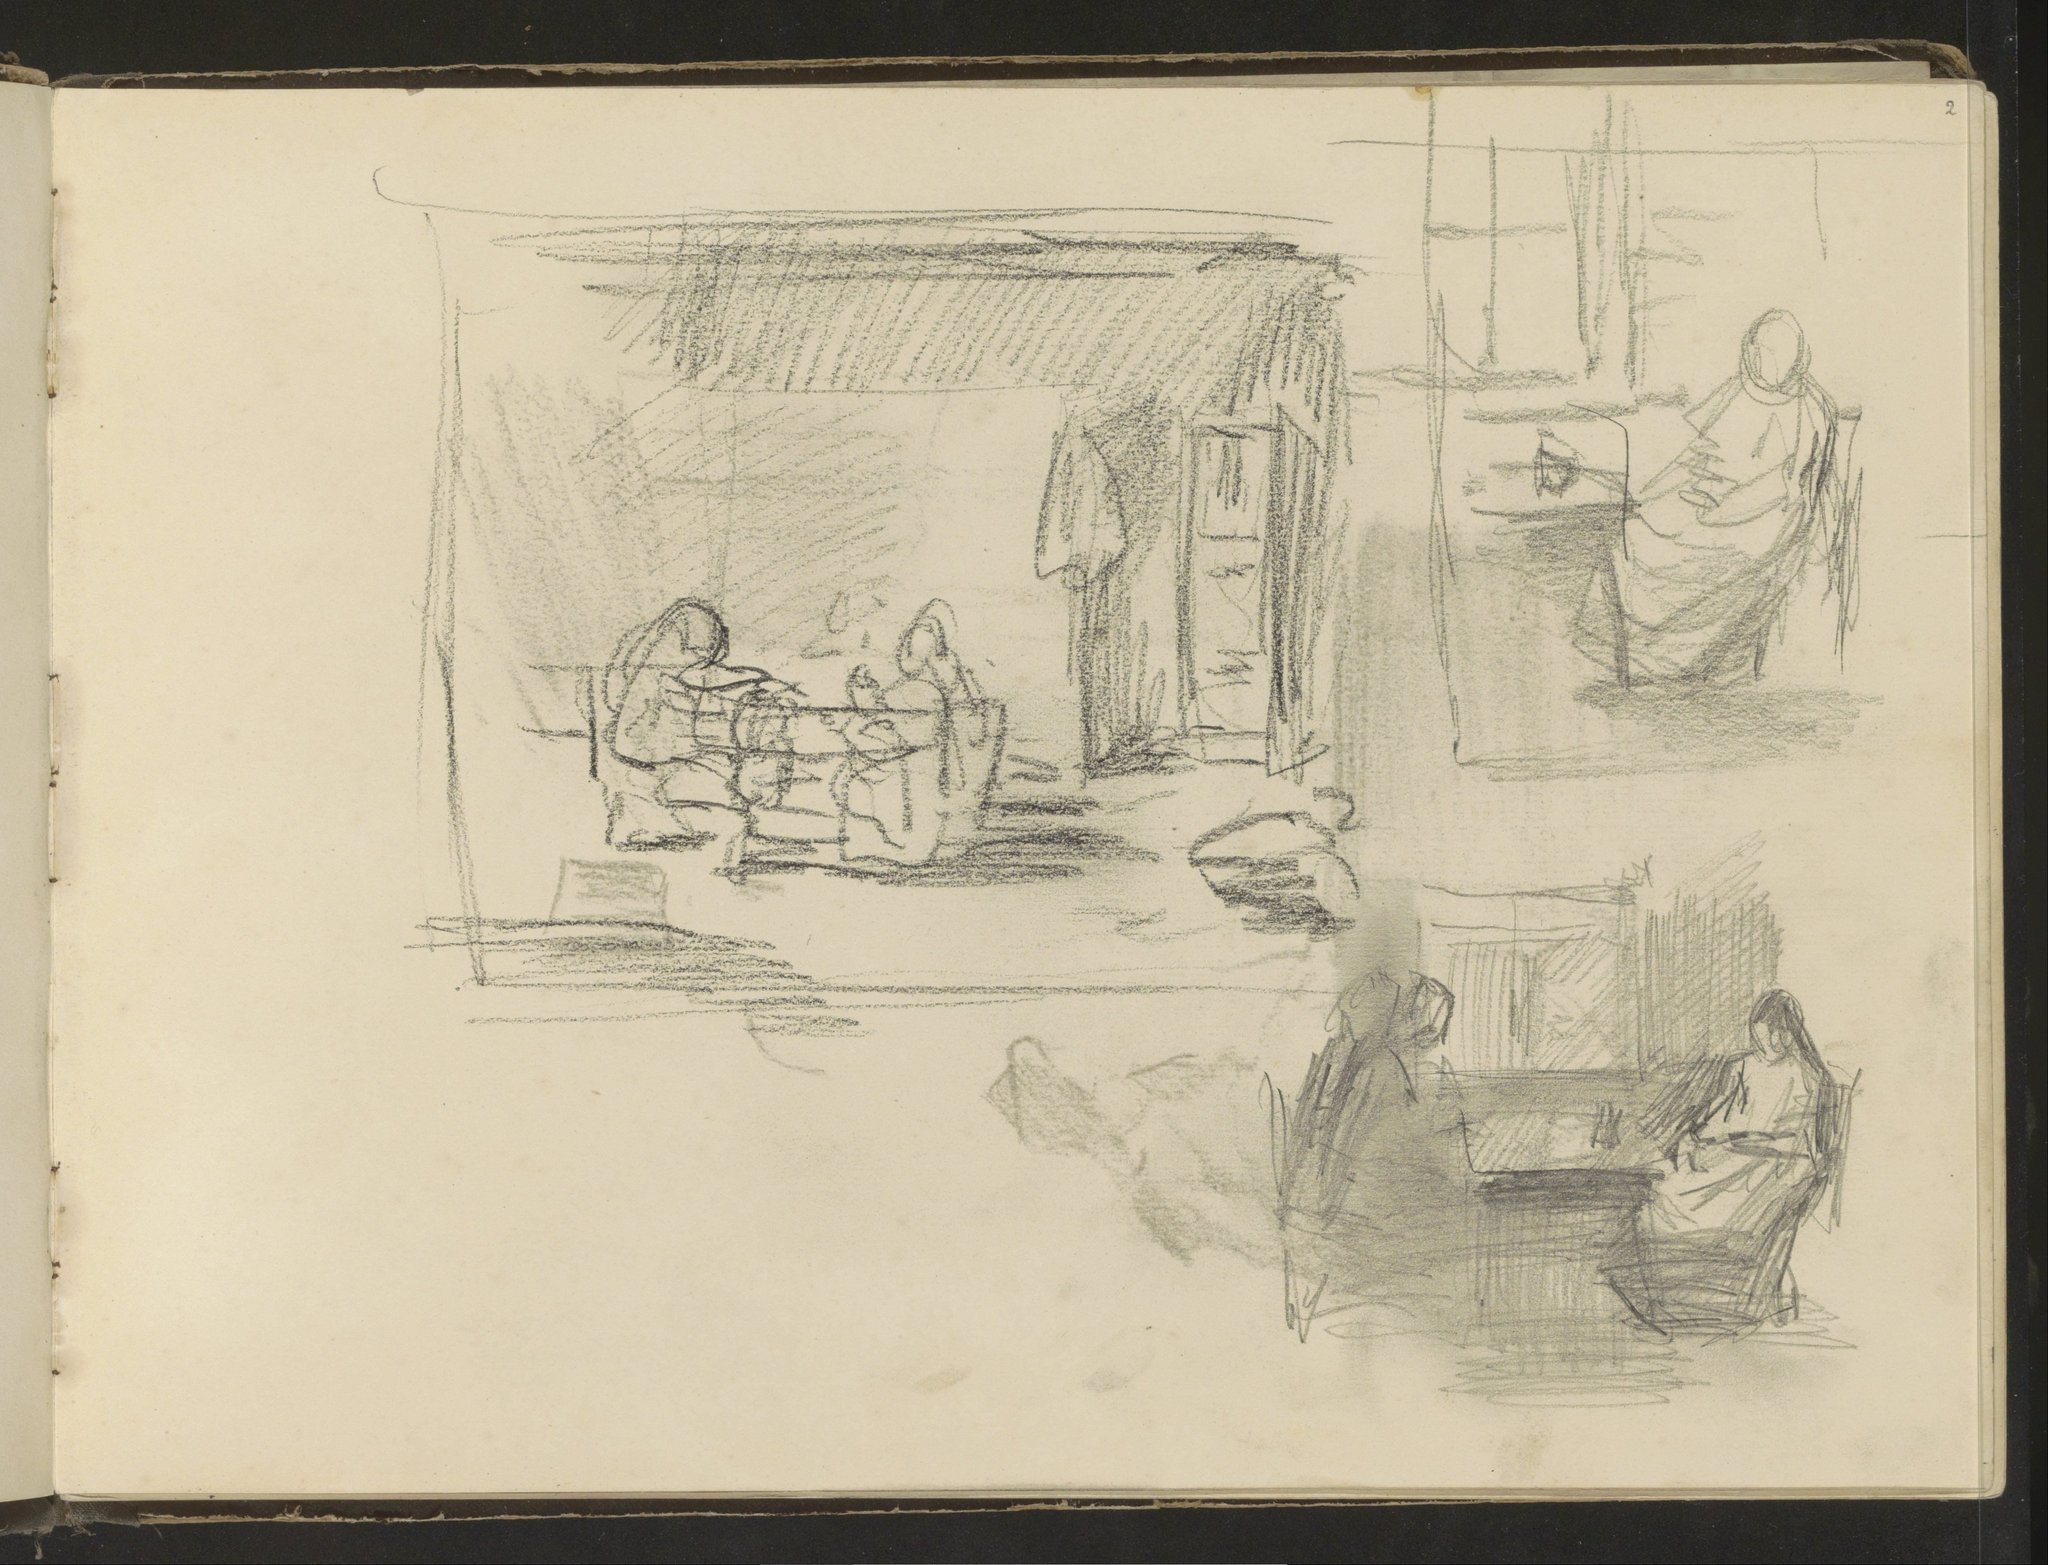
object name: sketchbook leaf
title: Interieurs met figuren zittend aan een tafel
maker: albert neuhuys (1844-1914)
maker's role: draughtsman, painter, print maker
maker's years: 1844-1914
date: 1854-1914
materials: chalk, paper, pencil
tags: sitting figure, table, interior of the house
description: Blad 2 recto uit een schetsboek met 43 bladen.